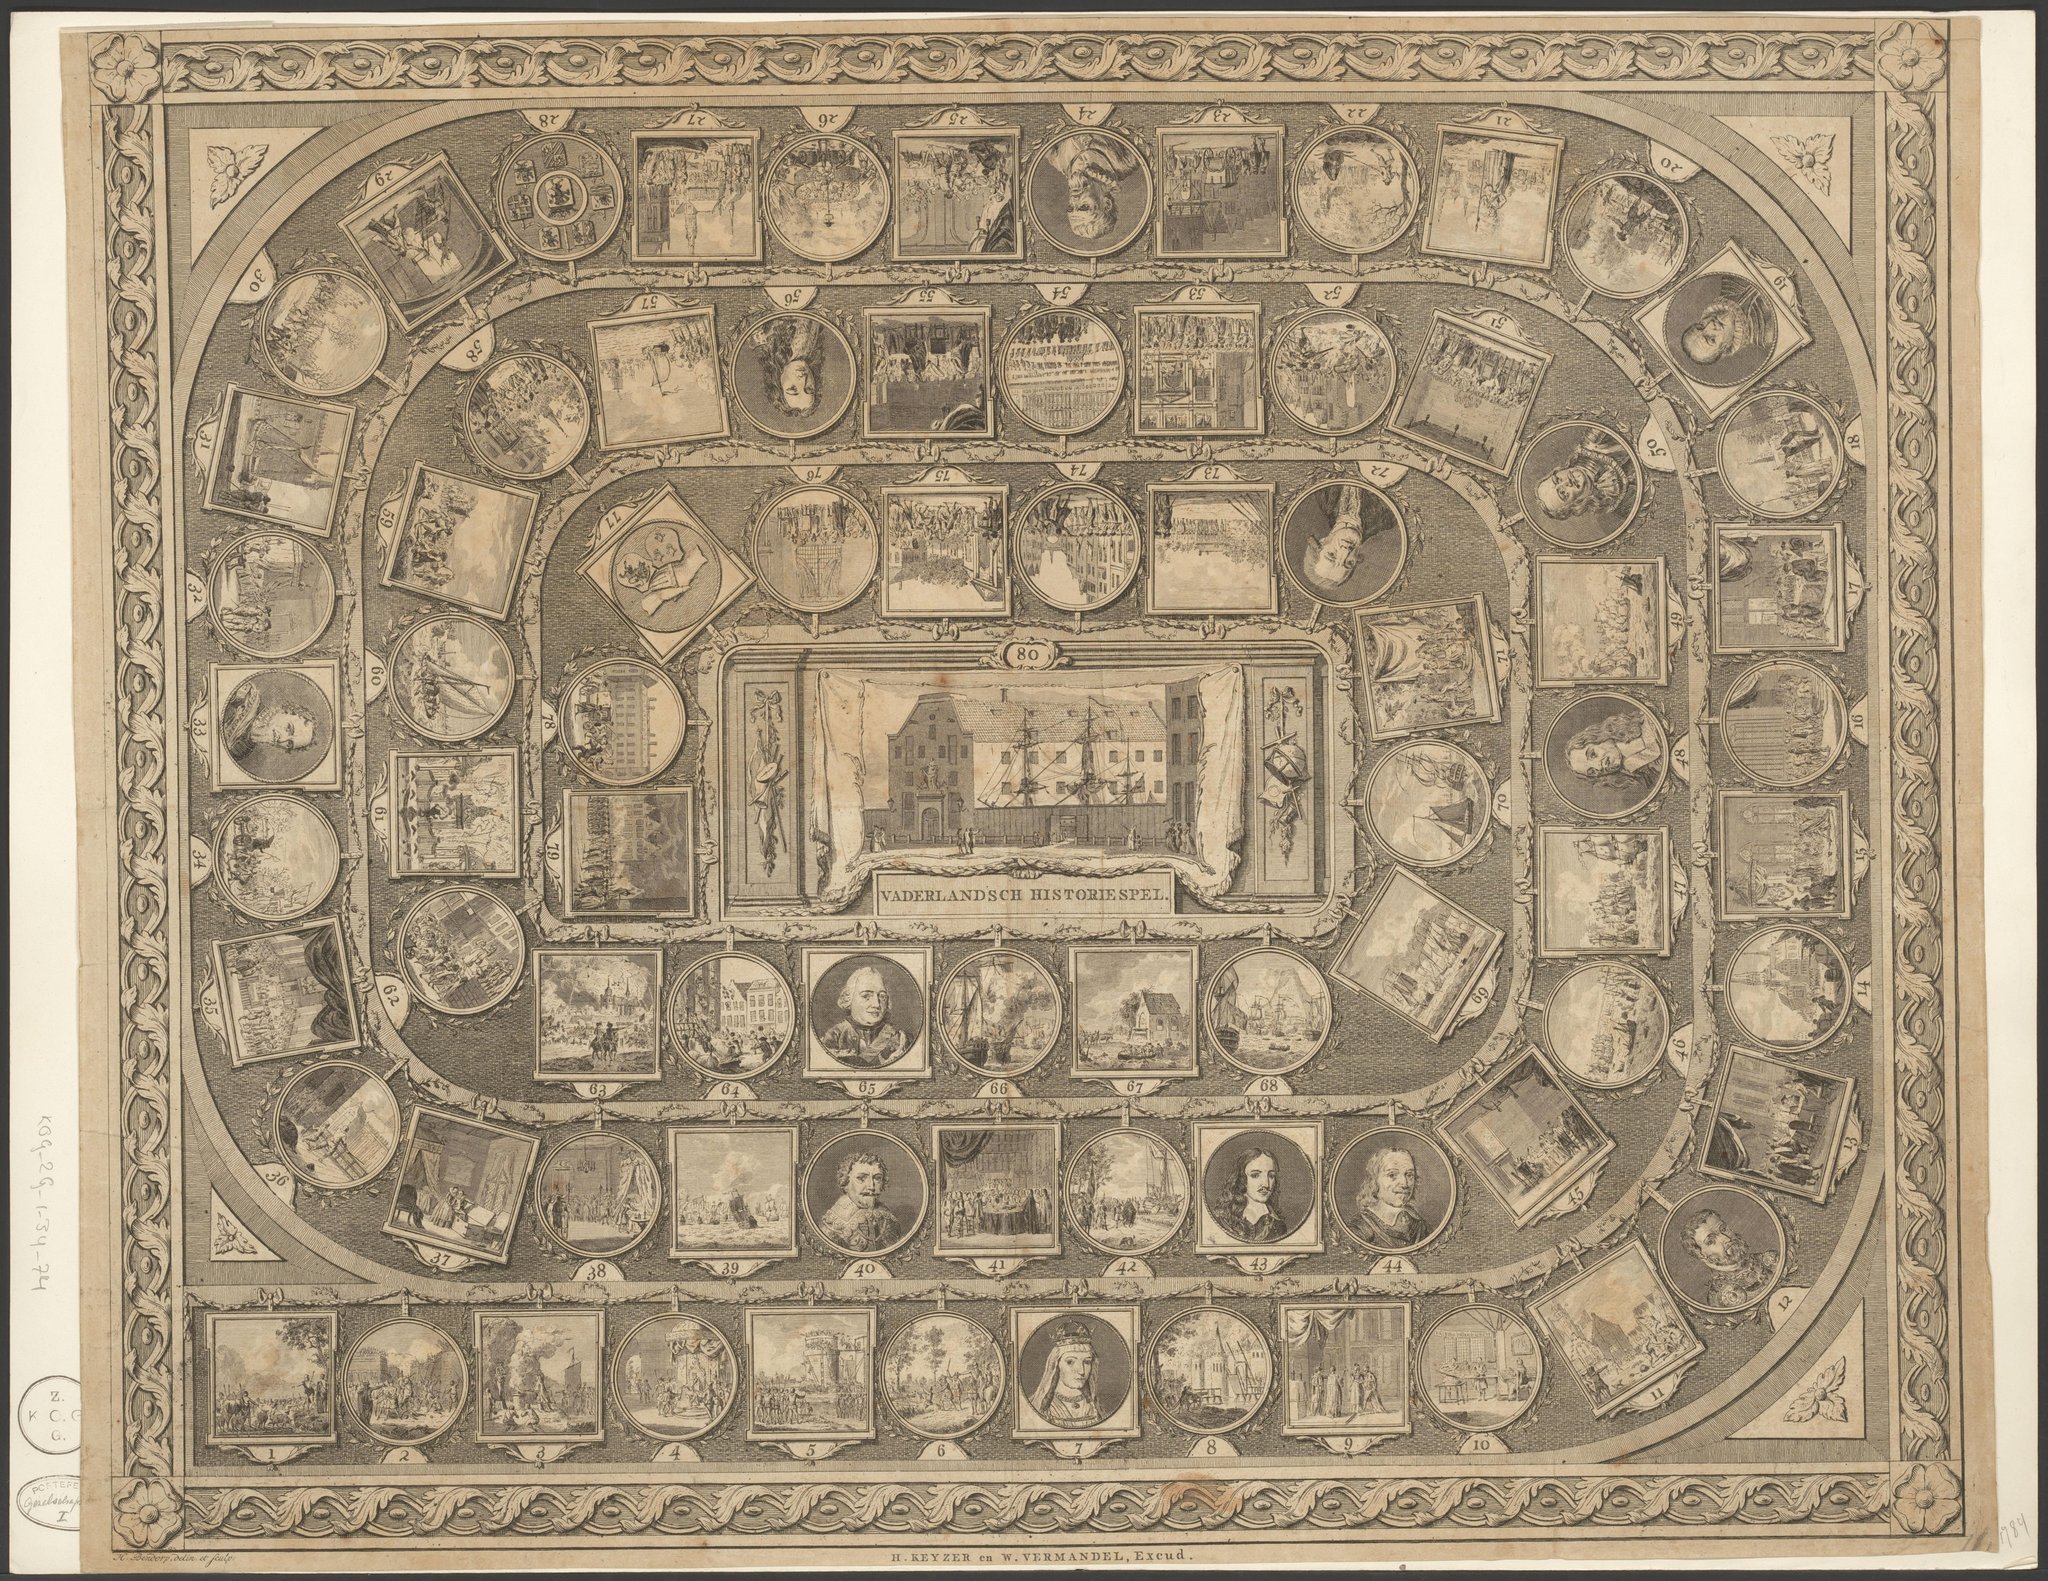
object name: gameboard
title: Vaderlandsch Historiespel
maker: johannes christiaan bendorp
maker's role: print maker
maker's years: 1766-1849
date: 1787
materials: paper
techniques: engraving, etching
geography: netherlands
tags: goose-game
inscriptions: collector's mark: Lugt 1641, collector's mark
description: Patriottisch bordspel over de vaderlandse geschiedenis. Ganzenbord met 80 genummerde vakjes beginnend bij nummer 1, de Bataafse Opstand en eindigend met nummer 80, de Kweekschool voor de Zeevaart te Amsterdam. Niet alleen gebeurtenissen maar ook portretten van belangrijke personen zijn opgenomen. De meest recente afgebeelde gebeurtenissen zijn uit het jaar 1786, nummer 79. Bij het bord behoort een boekje met de spelregels. Onderwerpsrubrieken binnen de Atlas Zeden en Gewoonten: Spel en Vermaak; gezelschapsspel, ganzenbord en dergelijke.